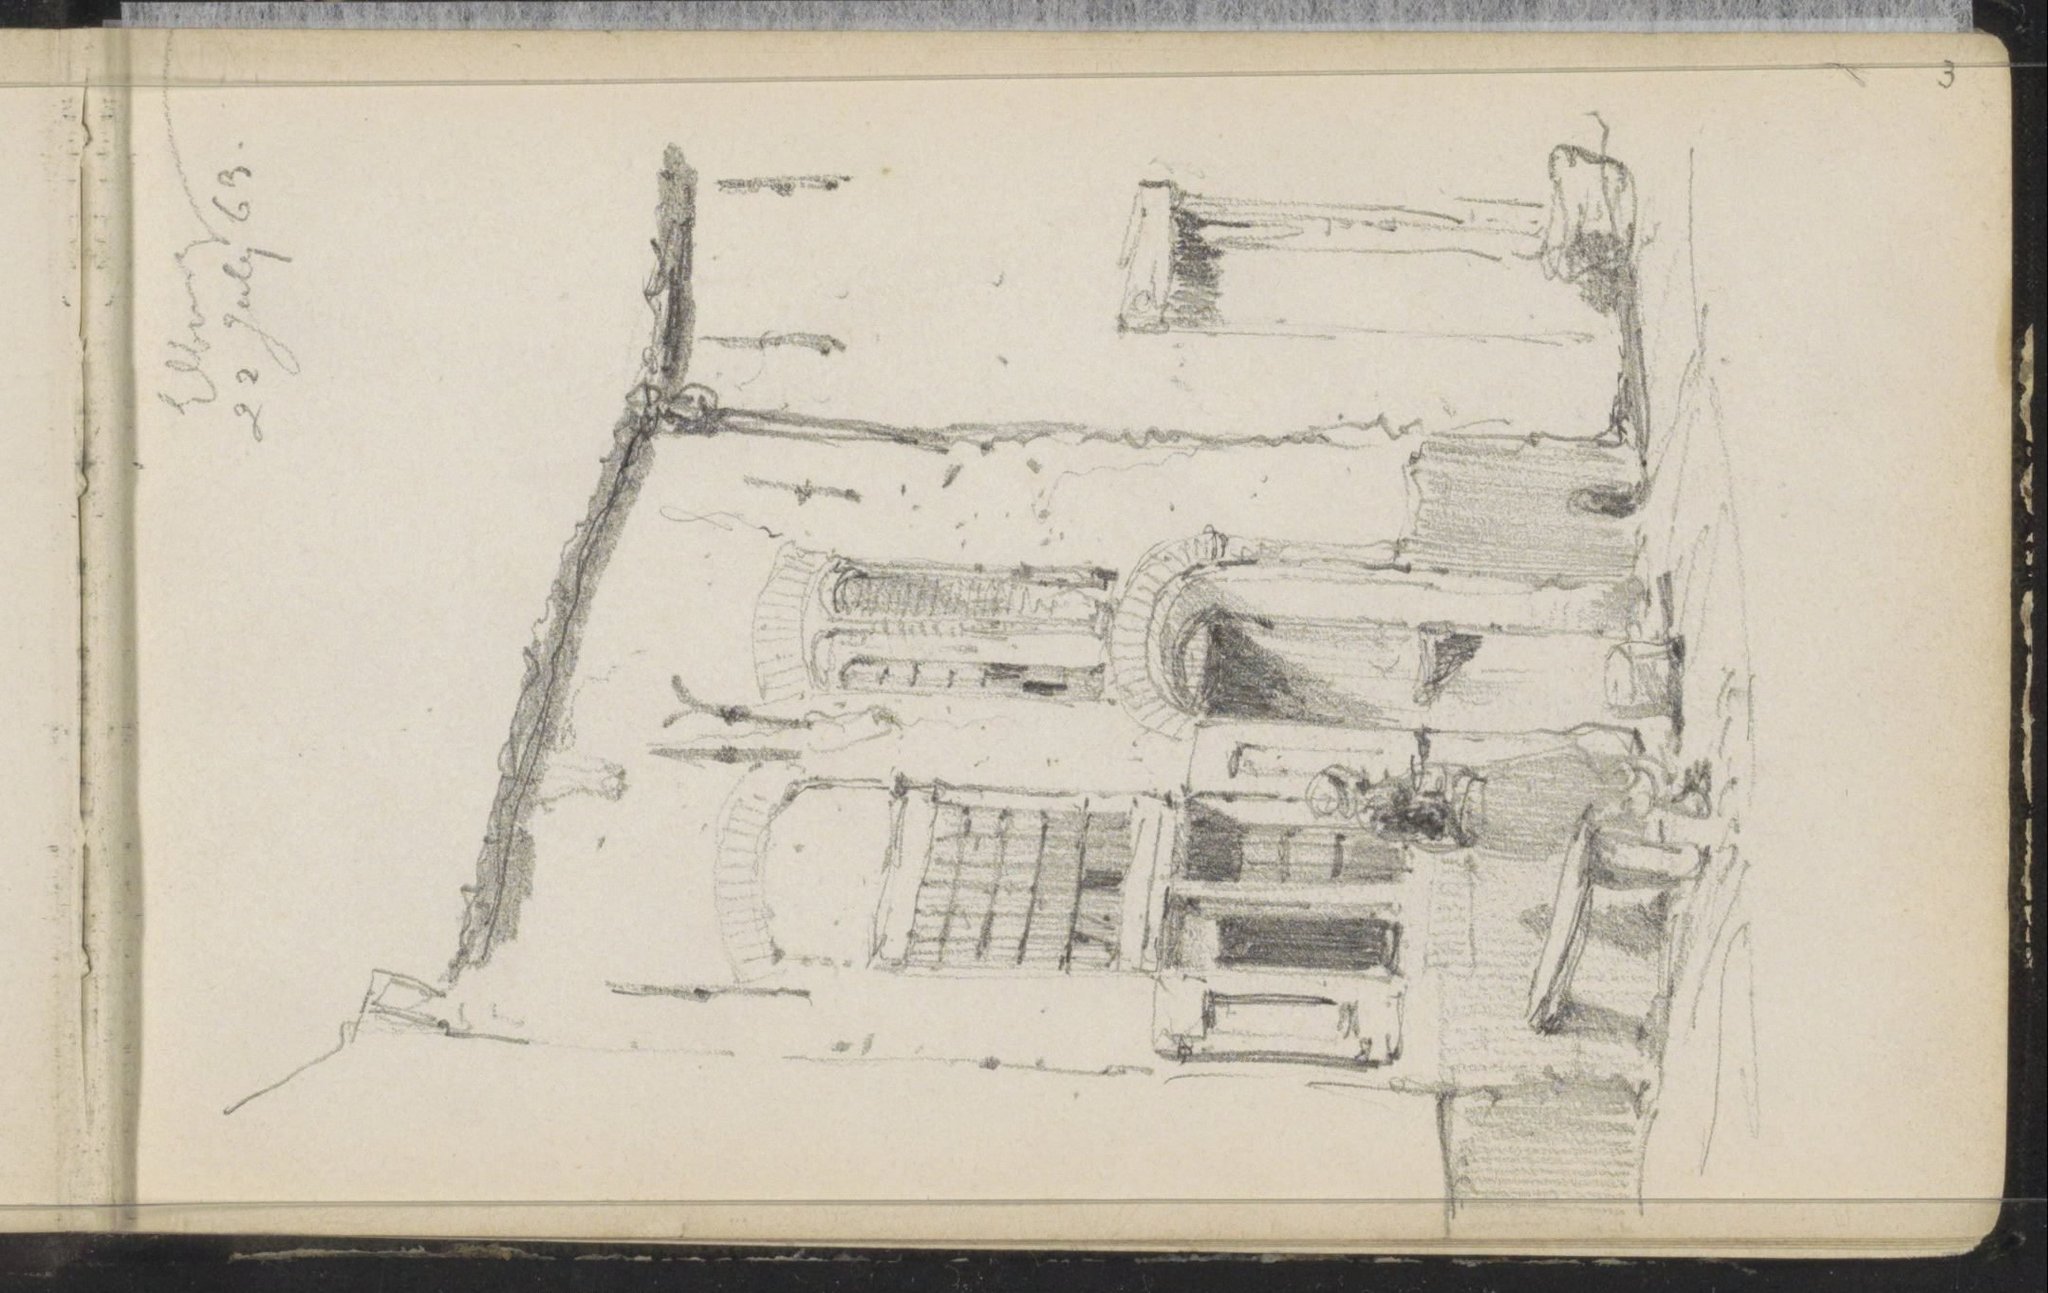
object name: sketchbook leaf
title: Gezicht op een huis in Elburg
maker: cornelis springer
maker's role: draughtsman, painter, print maker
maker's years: 1817-1891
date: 1863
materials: paper, pencil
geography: elburg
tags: urban housing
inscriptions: annotation: ‘Elburg’, date: ‘22 july 63’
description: Gezicht op een huis met muurankers in Elburg. Voor het huis staat een vrouw bij een bank. Blad 3 uit een schetsboek met 55 bladen vervaardigd op de Veluwe en in Noord-Duitsland.